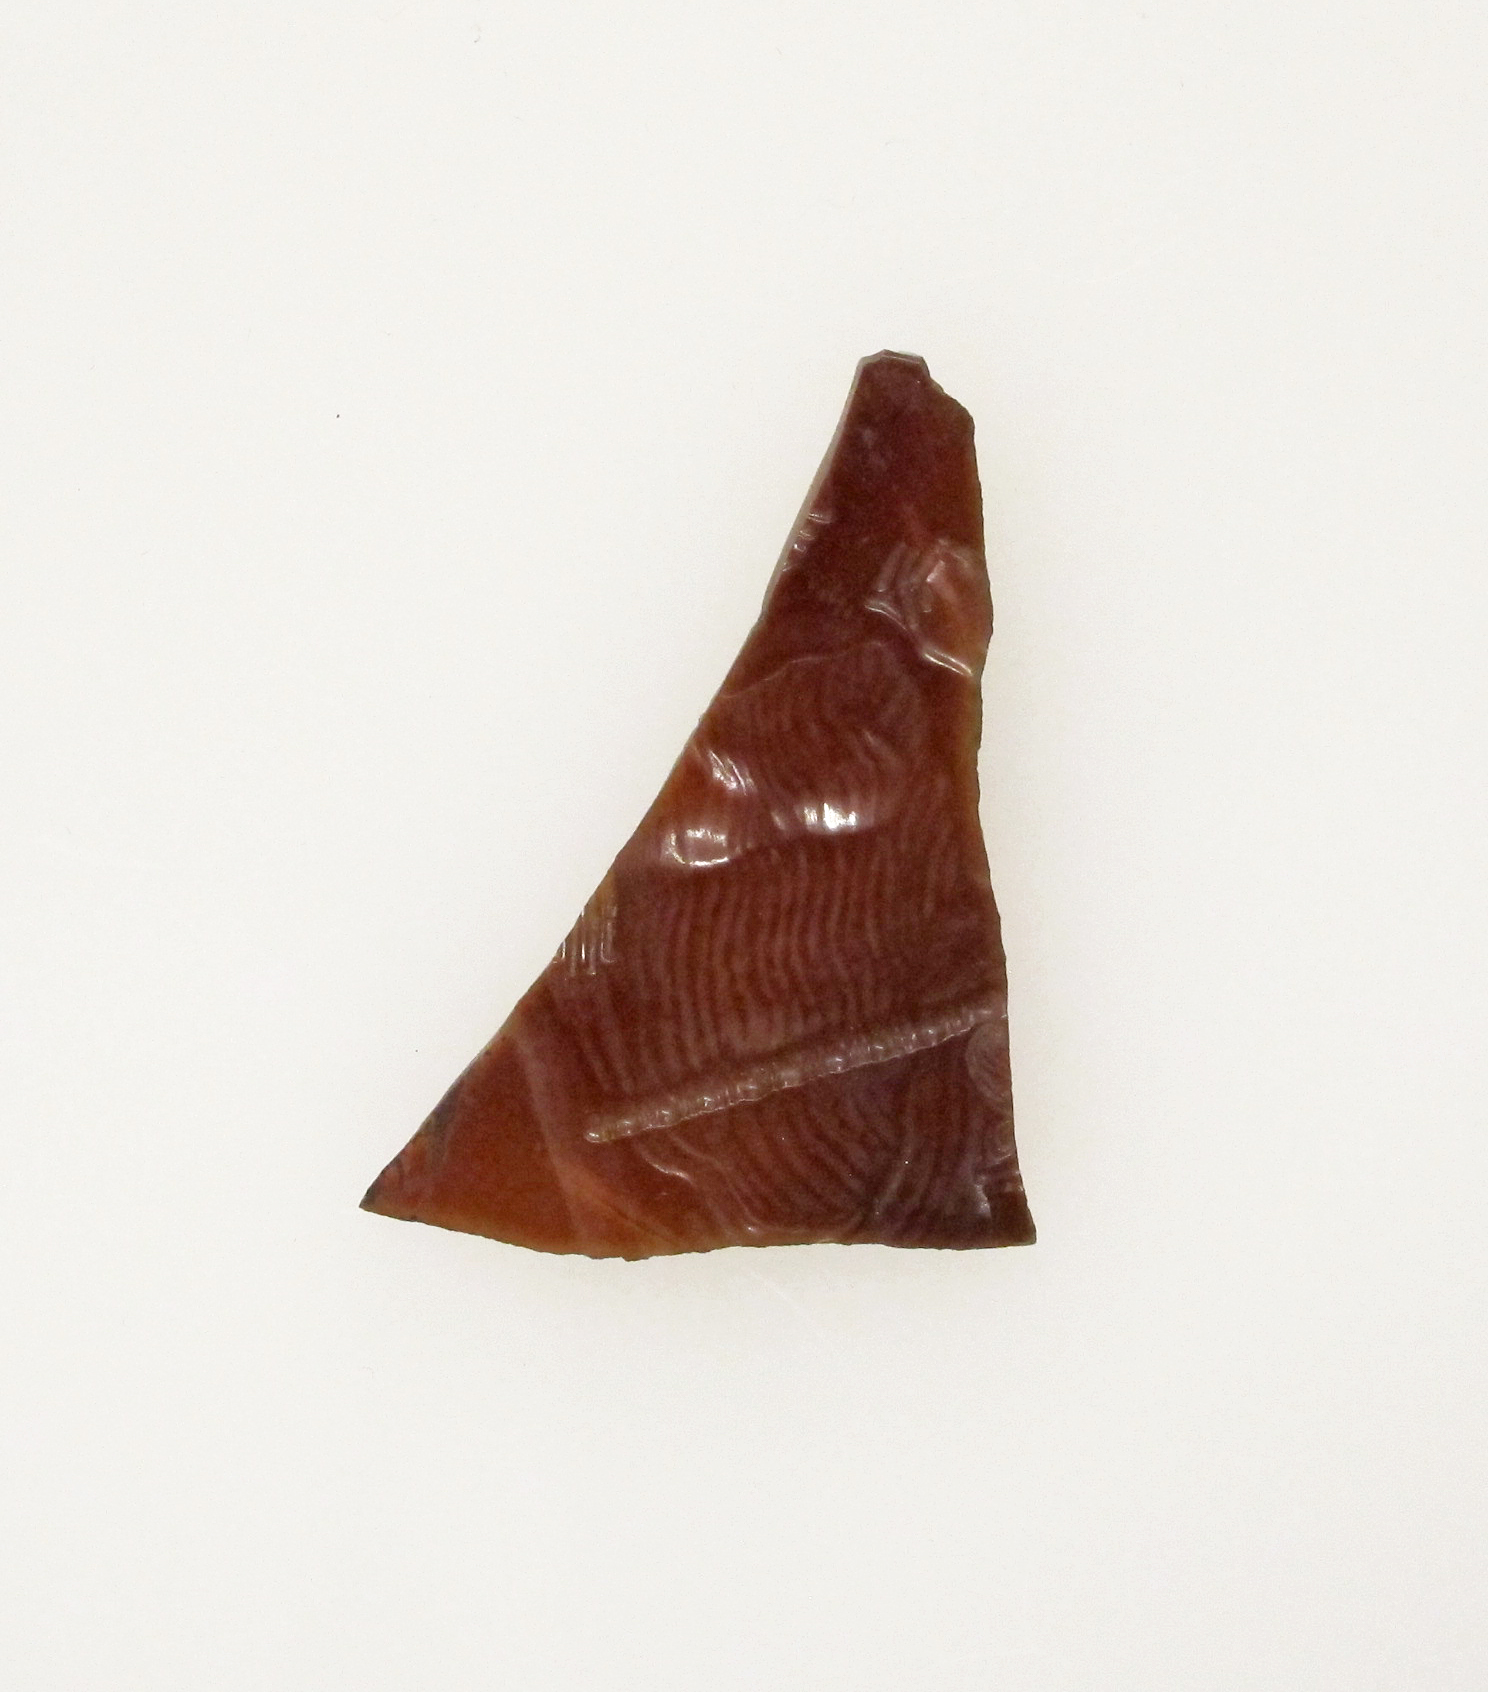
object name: inlay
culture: modern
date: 1500-1950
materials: glass